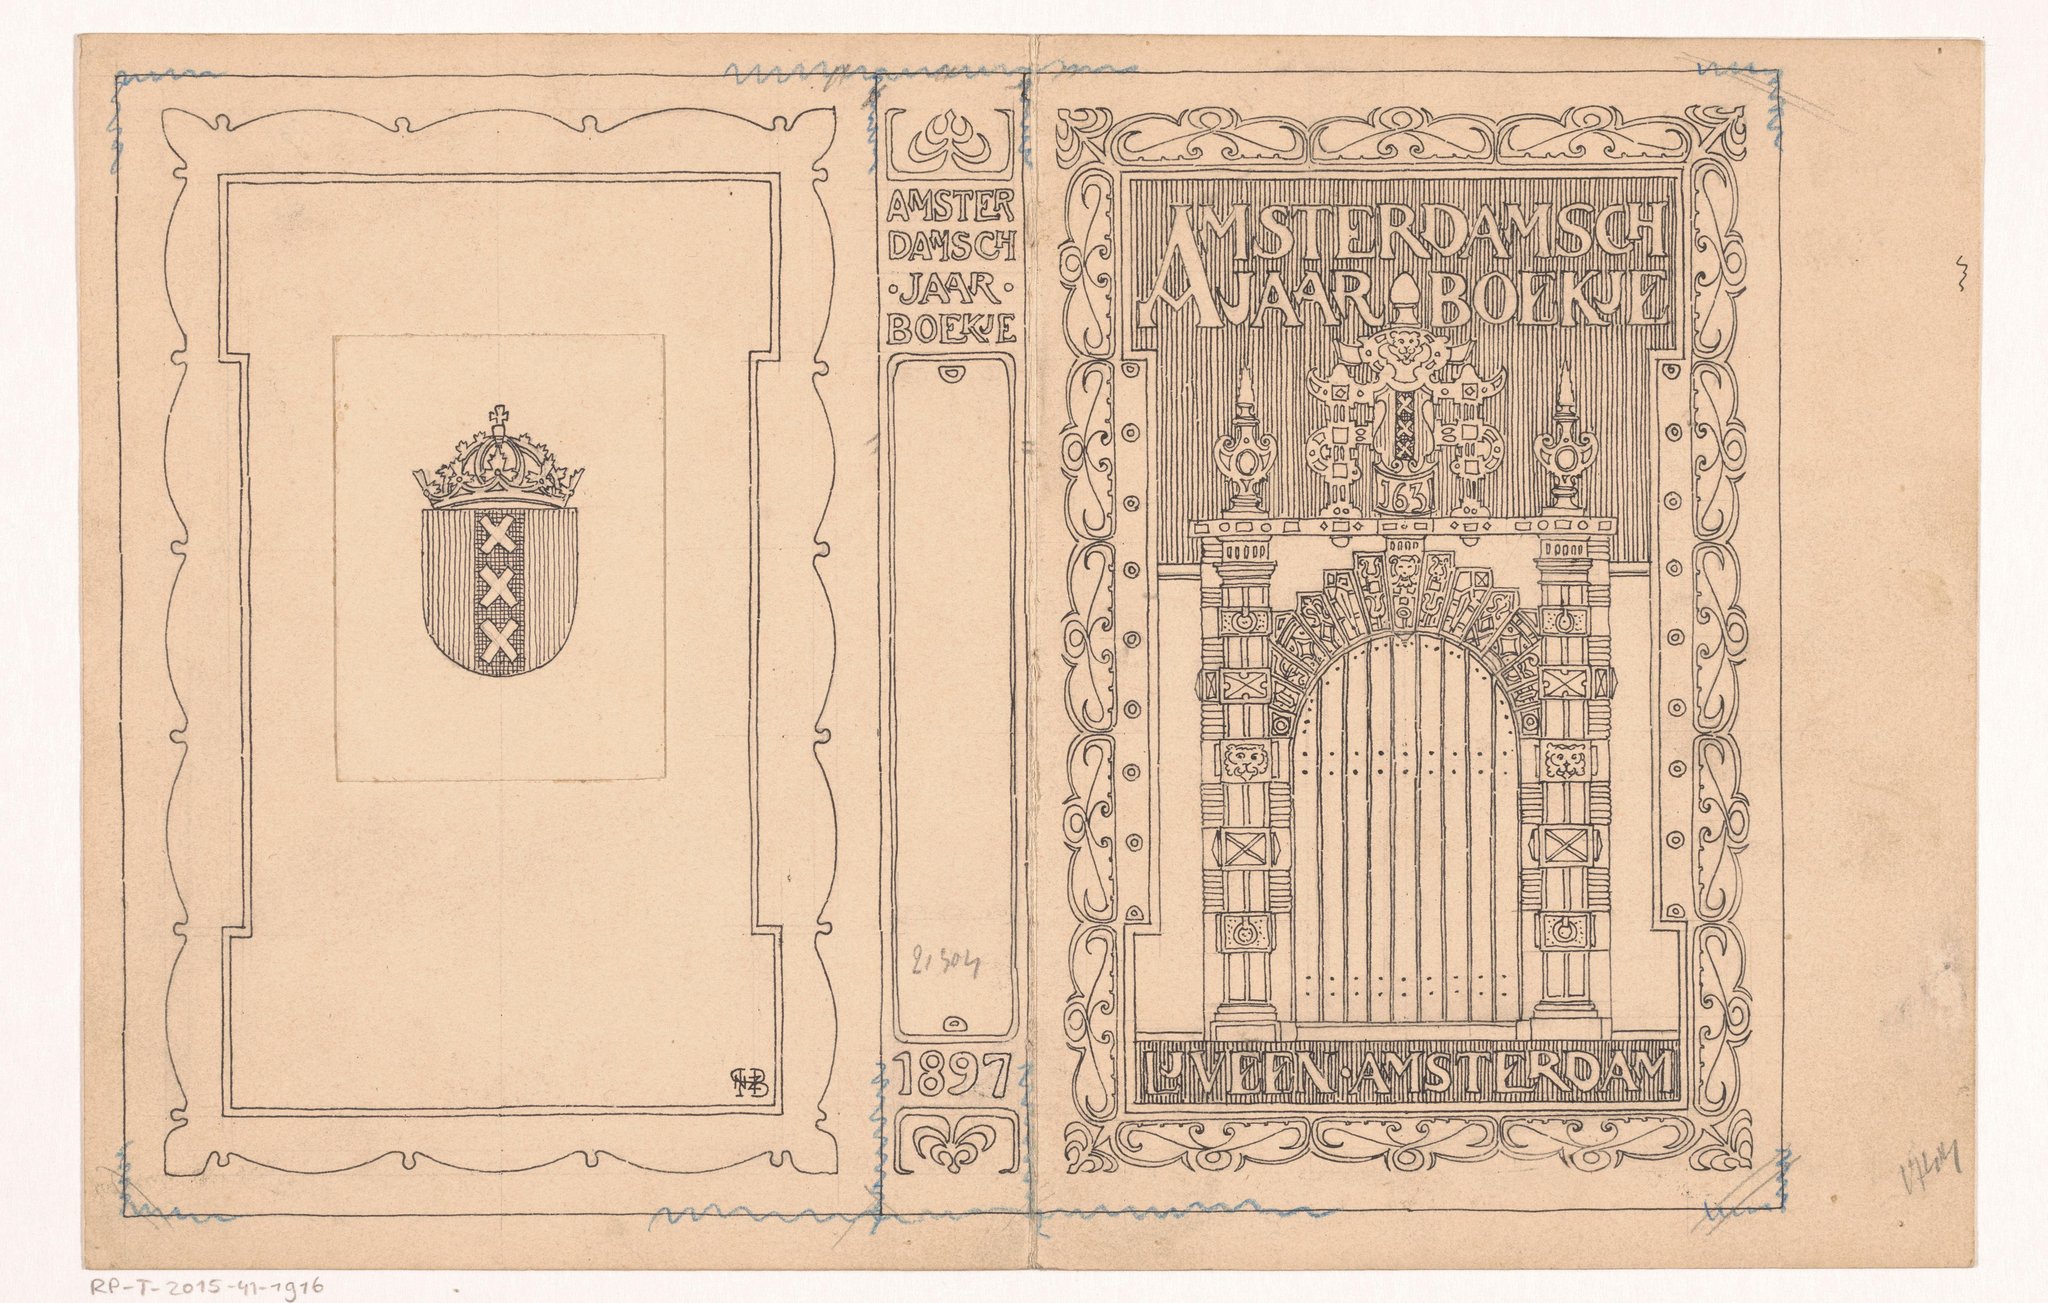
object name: study for binding design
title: Bandontwerp voor: Amsterdamsch Jaarboekje, 1897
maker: hendrik petrus berlage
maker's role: draughtsman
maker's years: 1856-1934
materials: ink, paper, pencil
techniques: pen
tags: parts of church exterior and annexes: portal, coat of arms (as symbol of the state, etc.) (+ city; municipal), ornaments ~ art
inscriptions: :, monogram:, collector's mark: Lugt 2228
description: Ontwerp met op het voorplat een ornamentele poort of portaal met daarboven het nummer 163, het wapen van de stad Amsterdam en de titel van het boek. Het geheel is gevat in een ornamenteel kader met bloem- en lijnmotieven. Op het achterplat het stadswapen van Amsterdam met een kroon.